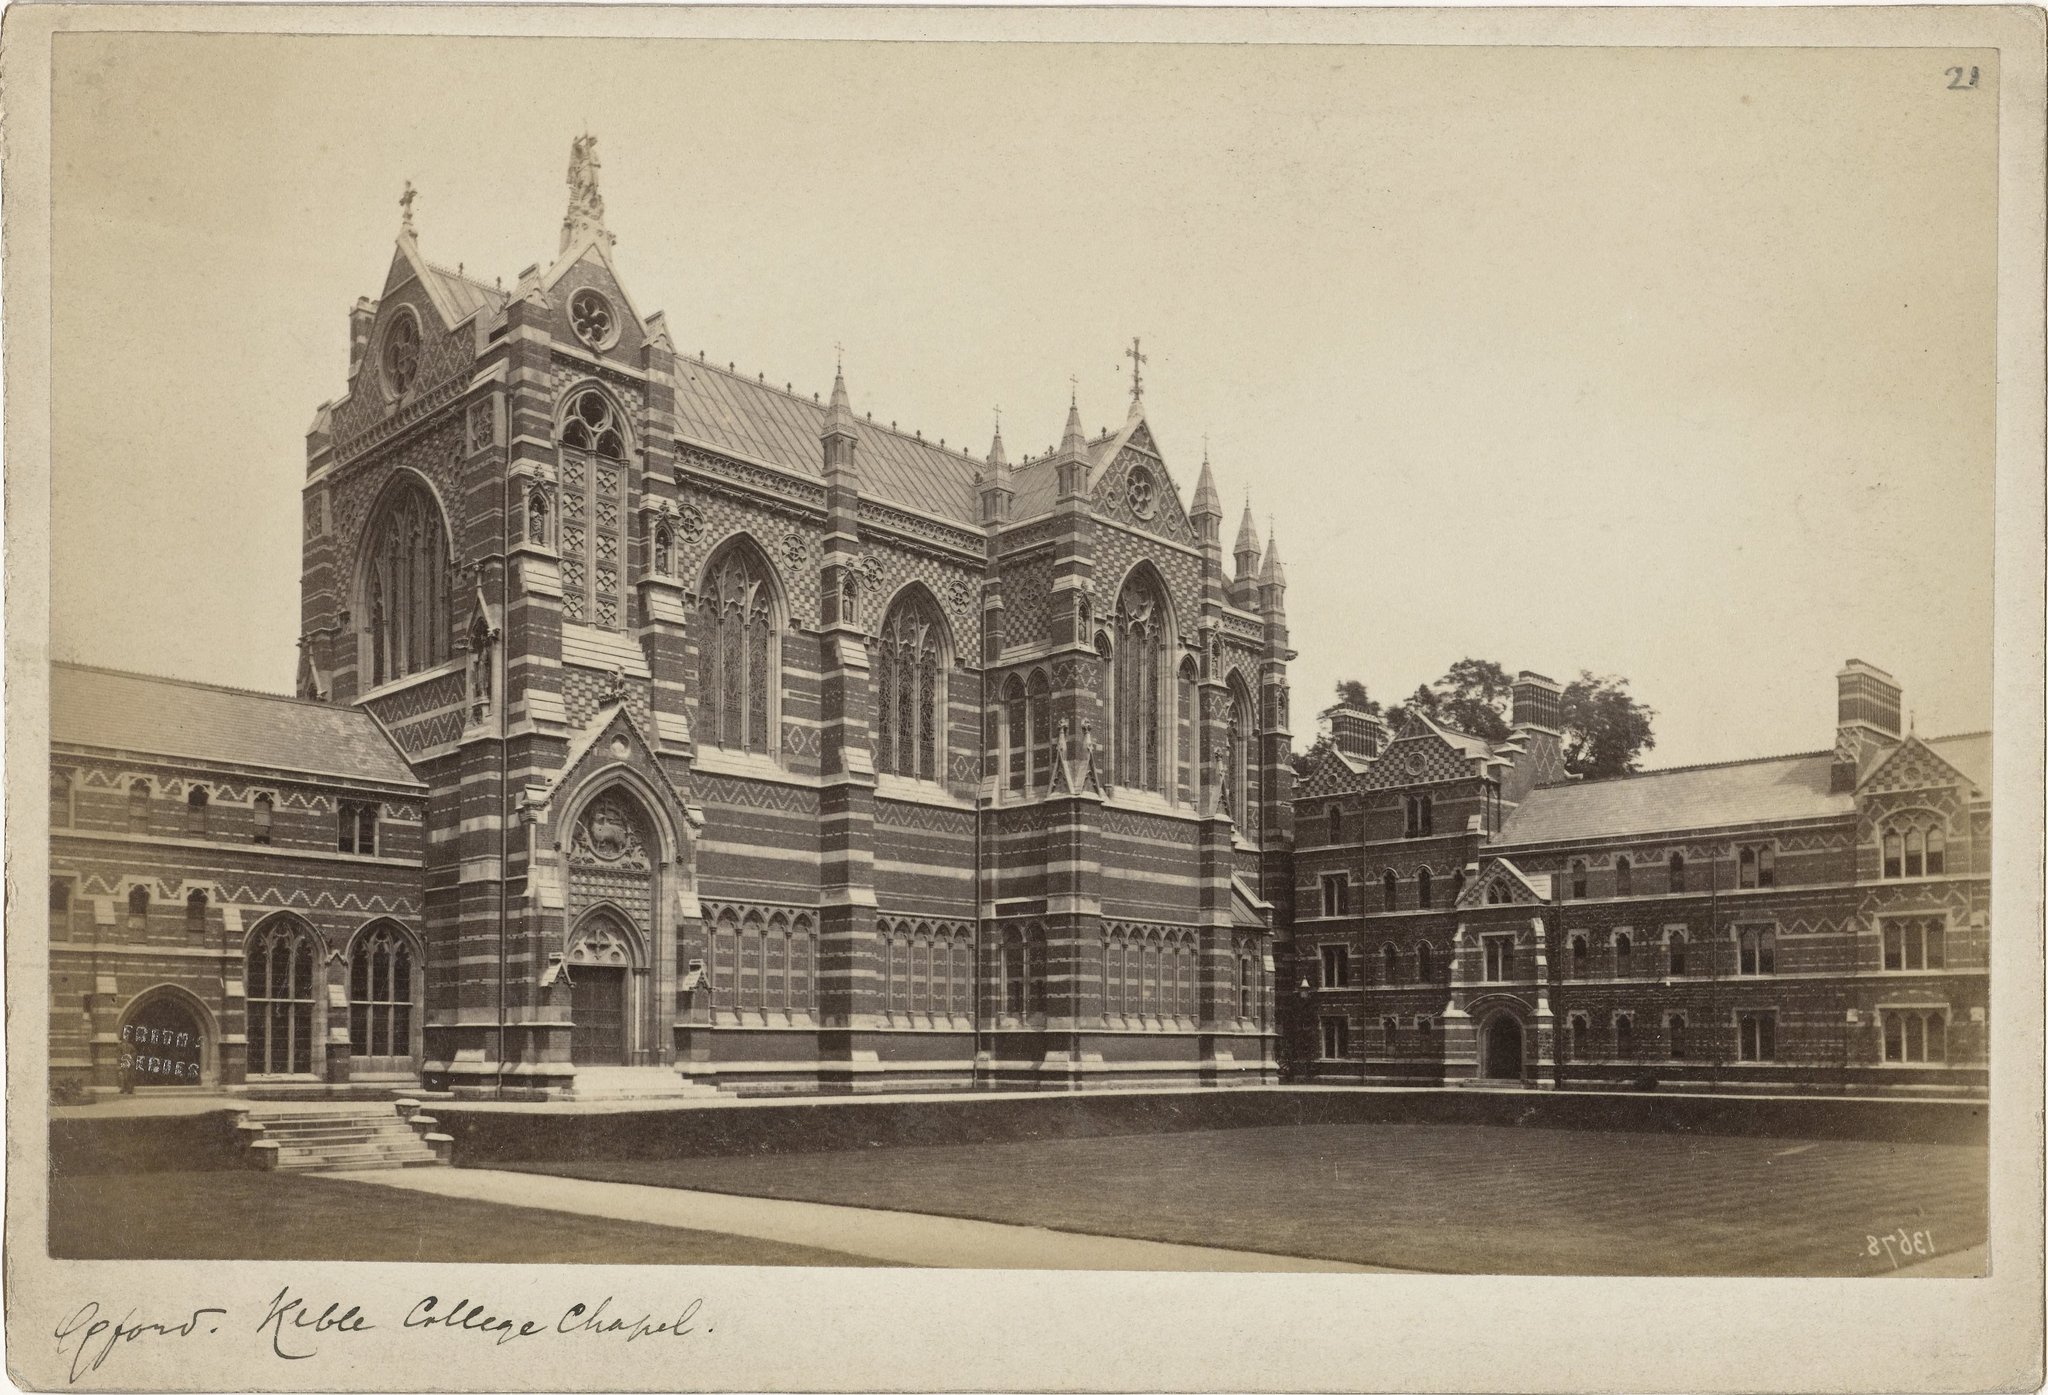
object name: photograph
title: Keble College Chapel in Oxford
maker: francis frith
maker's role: publisher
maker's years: 1822-1898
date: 1864-1898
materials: cardboard, paper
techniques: albumen print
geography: oxford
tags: university building, college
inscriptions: number: ‘21’, number: ‘13678’